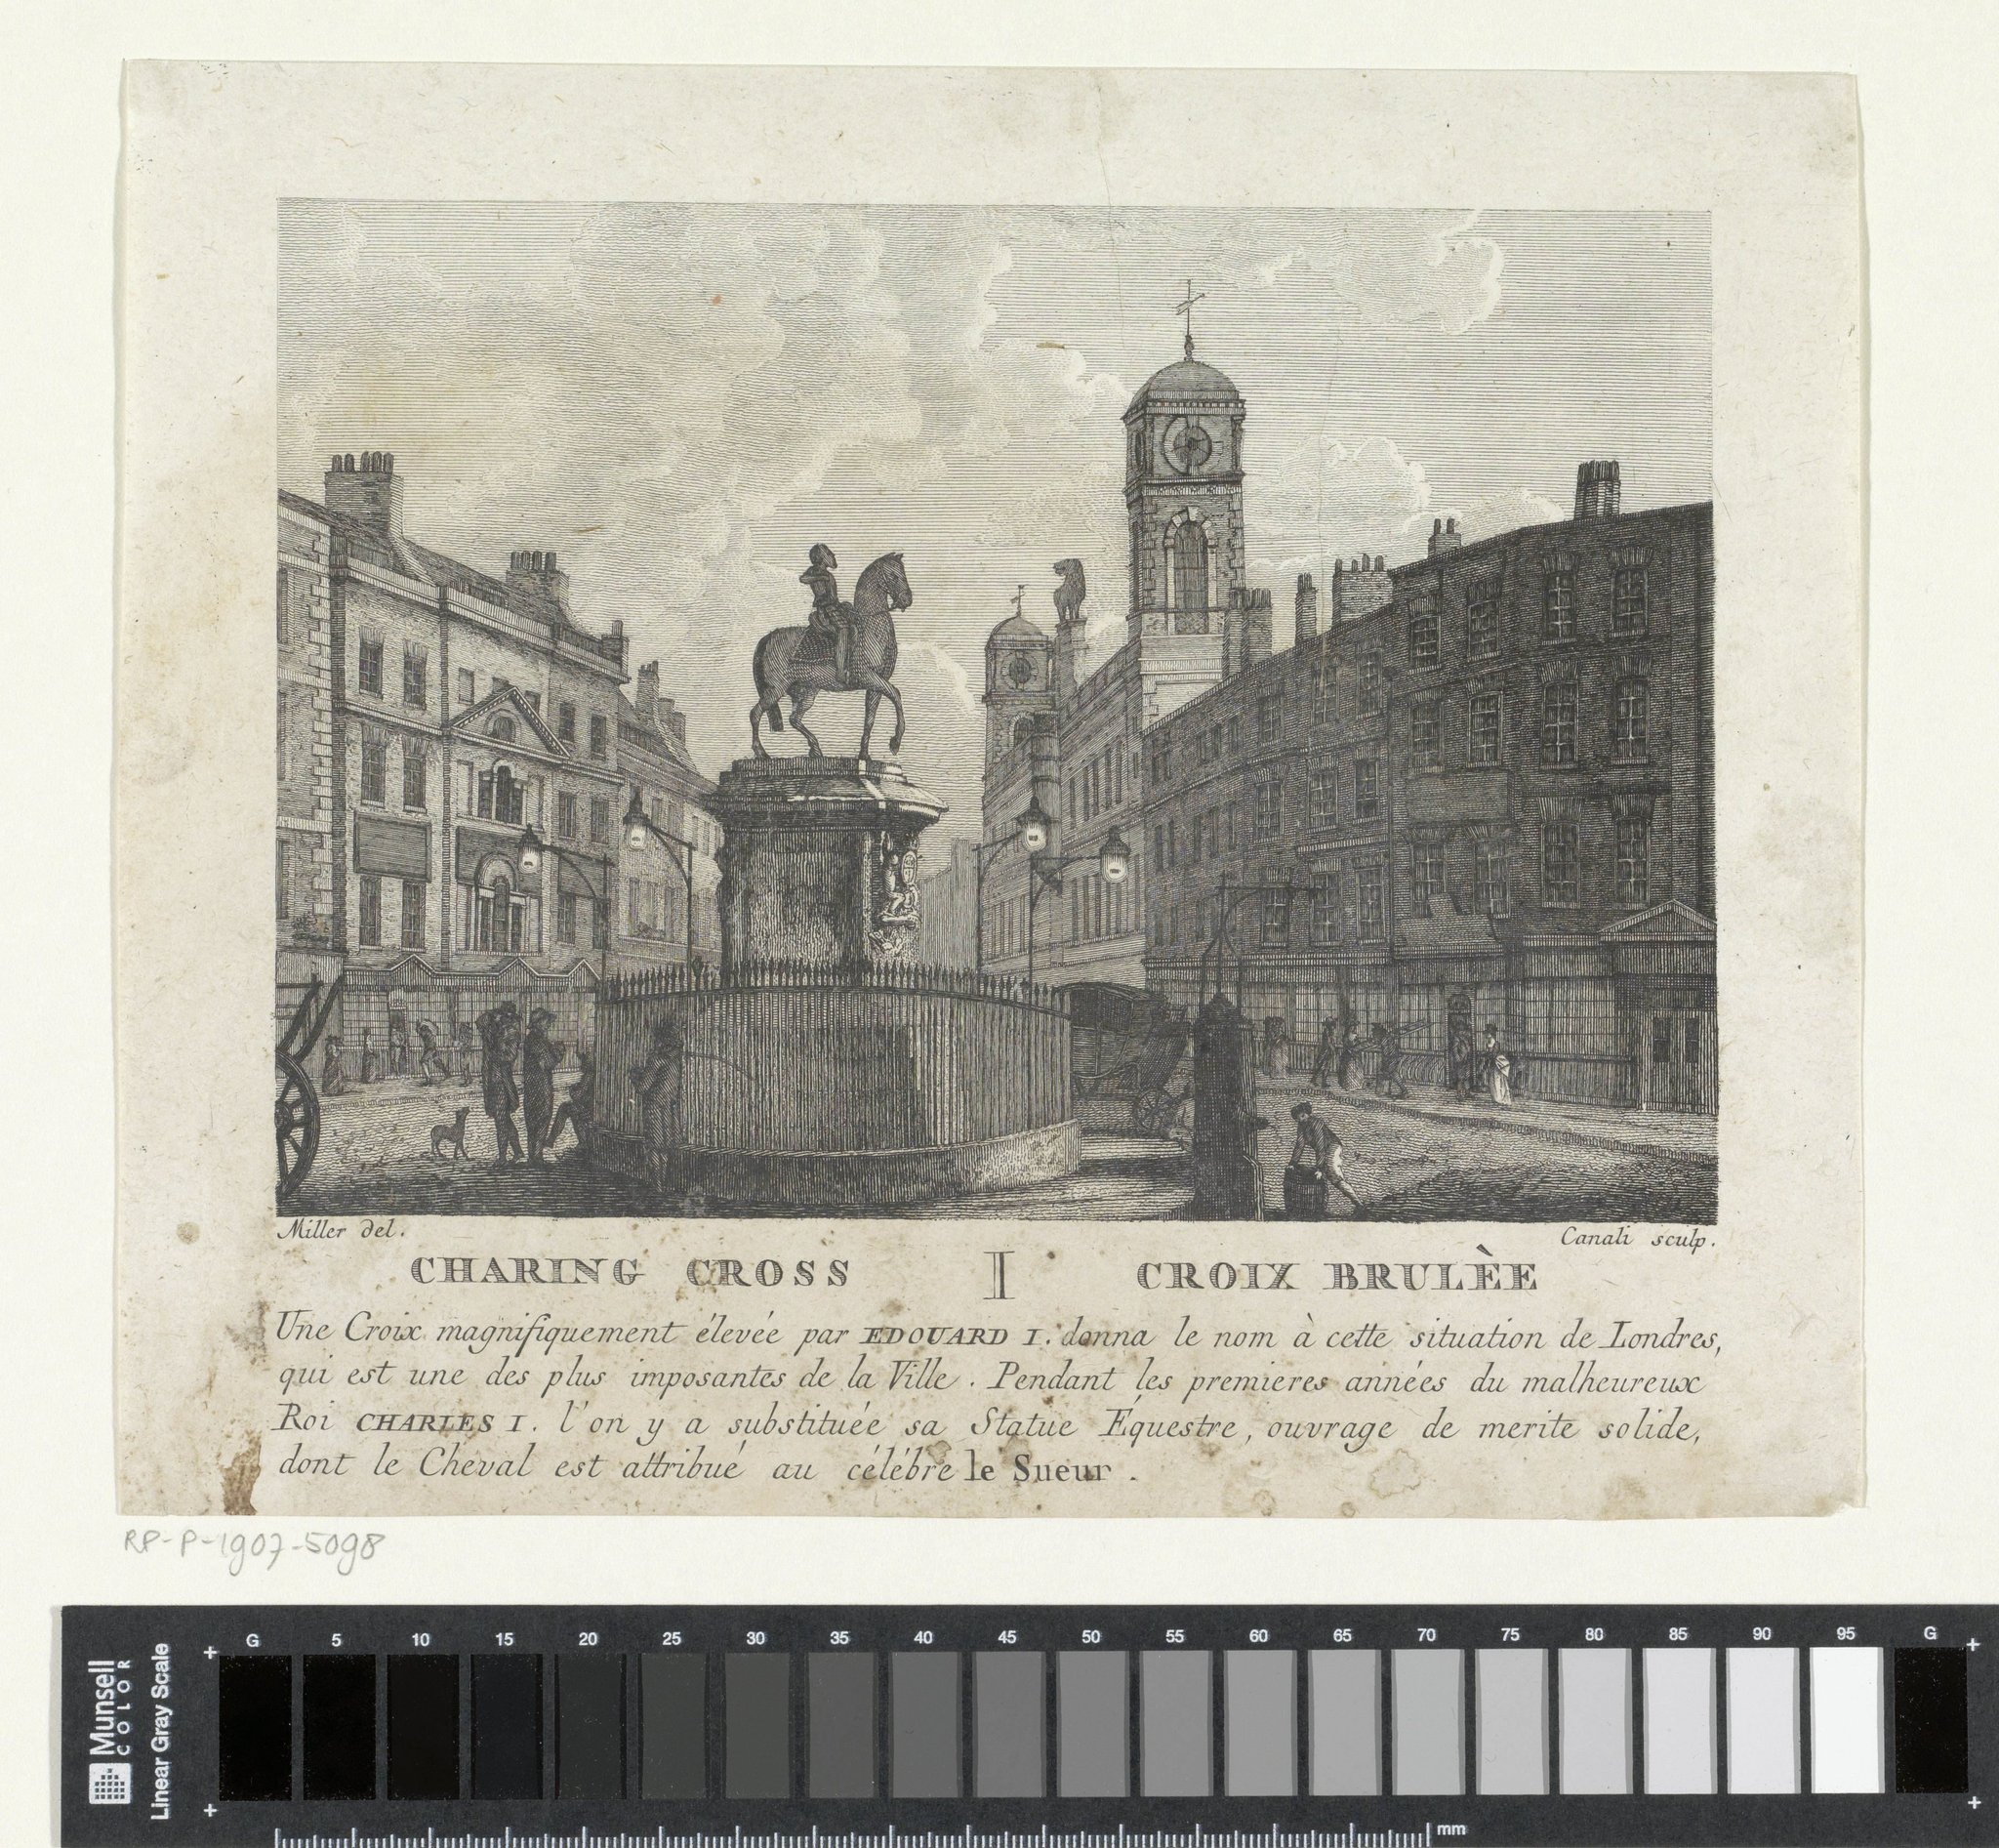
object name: print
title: Charing Cross / Crois Brulèe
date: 1776-1790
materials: paper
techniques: etching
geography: italy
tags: london, karel i (koning van engeland), city-view in general; 'veduta', equestrian statue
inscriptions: collector's mark: Lugt 2228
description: Gezicht op Charing Cross te Londen, met op de voorgrond het ruiterstandbeeld van Karel I. Op de achtergrond rechts Northumberland House. Tekst in ondermarge.